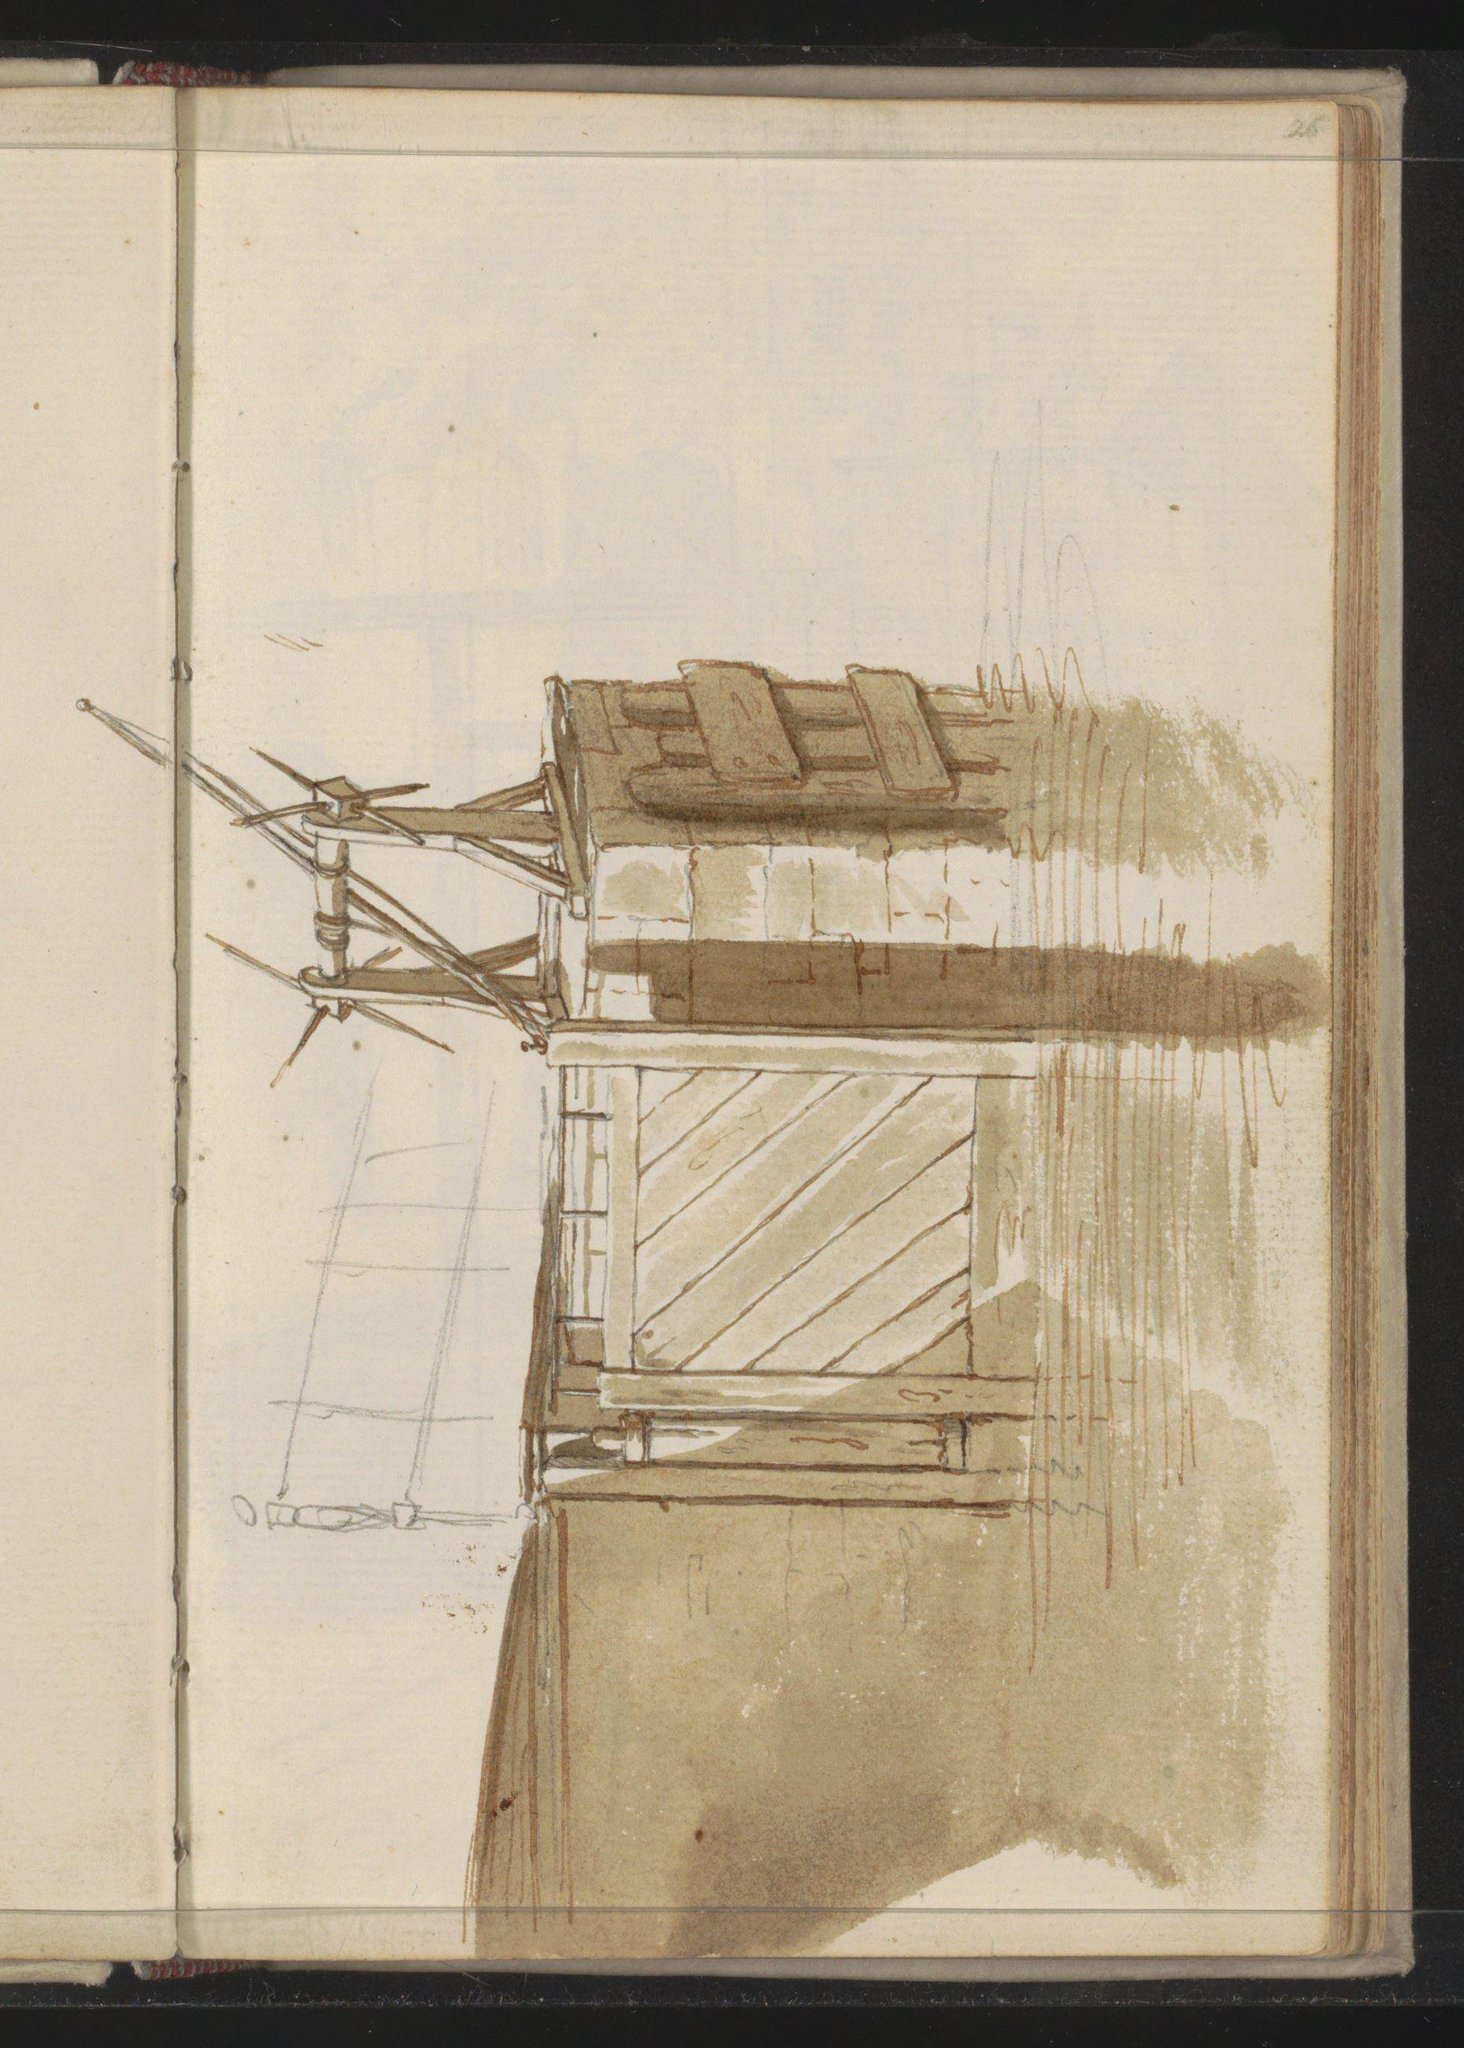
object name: sketchbook leaf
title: Sluis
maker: johannes huibert prins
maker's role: draughtsman, painter, print maker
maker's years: 1757-1806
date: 1783-1797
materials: ink, paper, pencil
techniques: brush, pen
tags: lift-lock, canal lock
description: Pagina 26 uit een schetsboek met 175 pagina's.